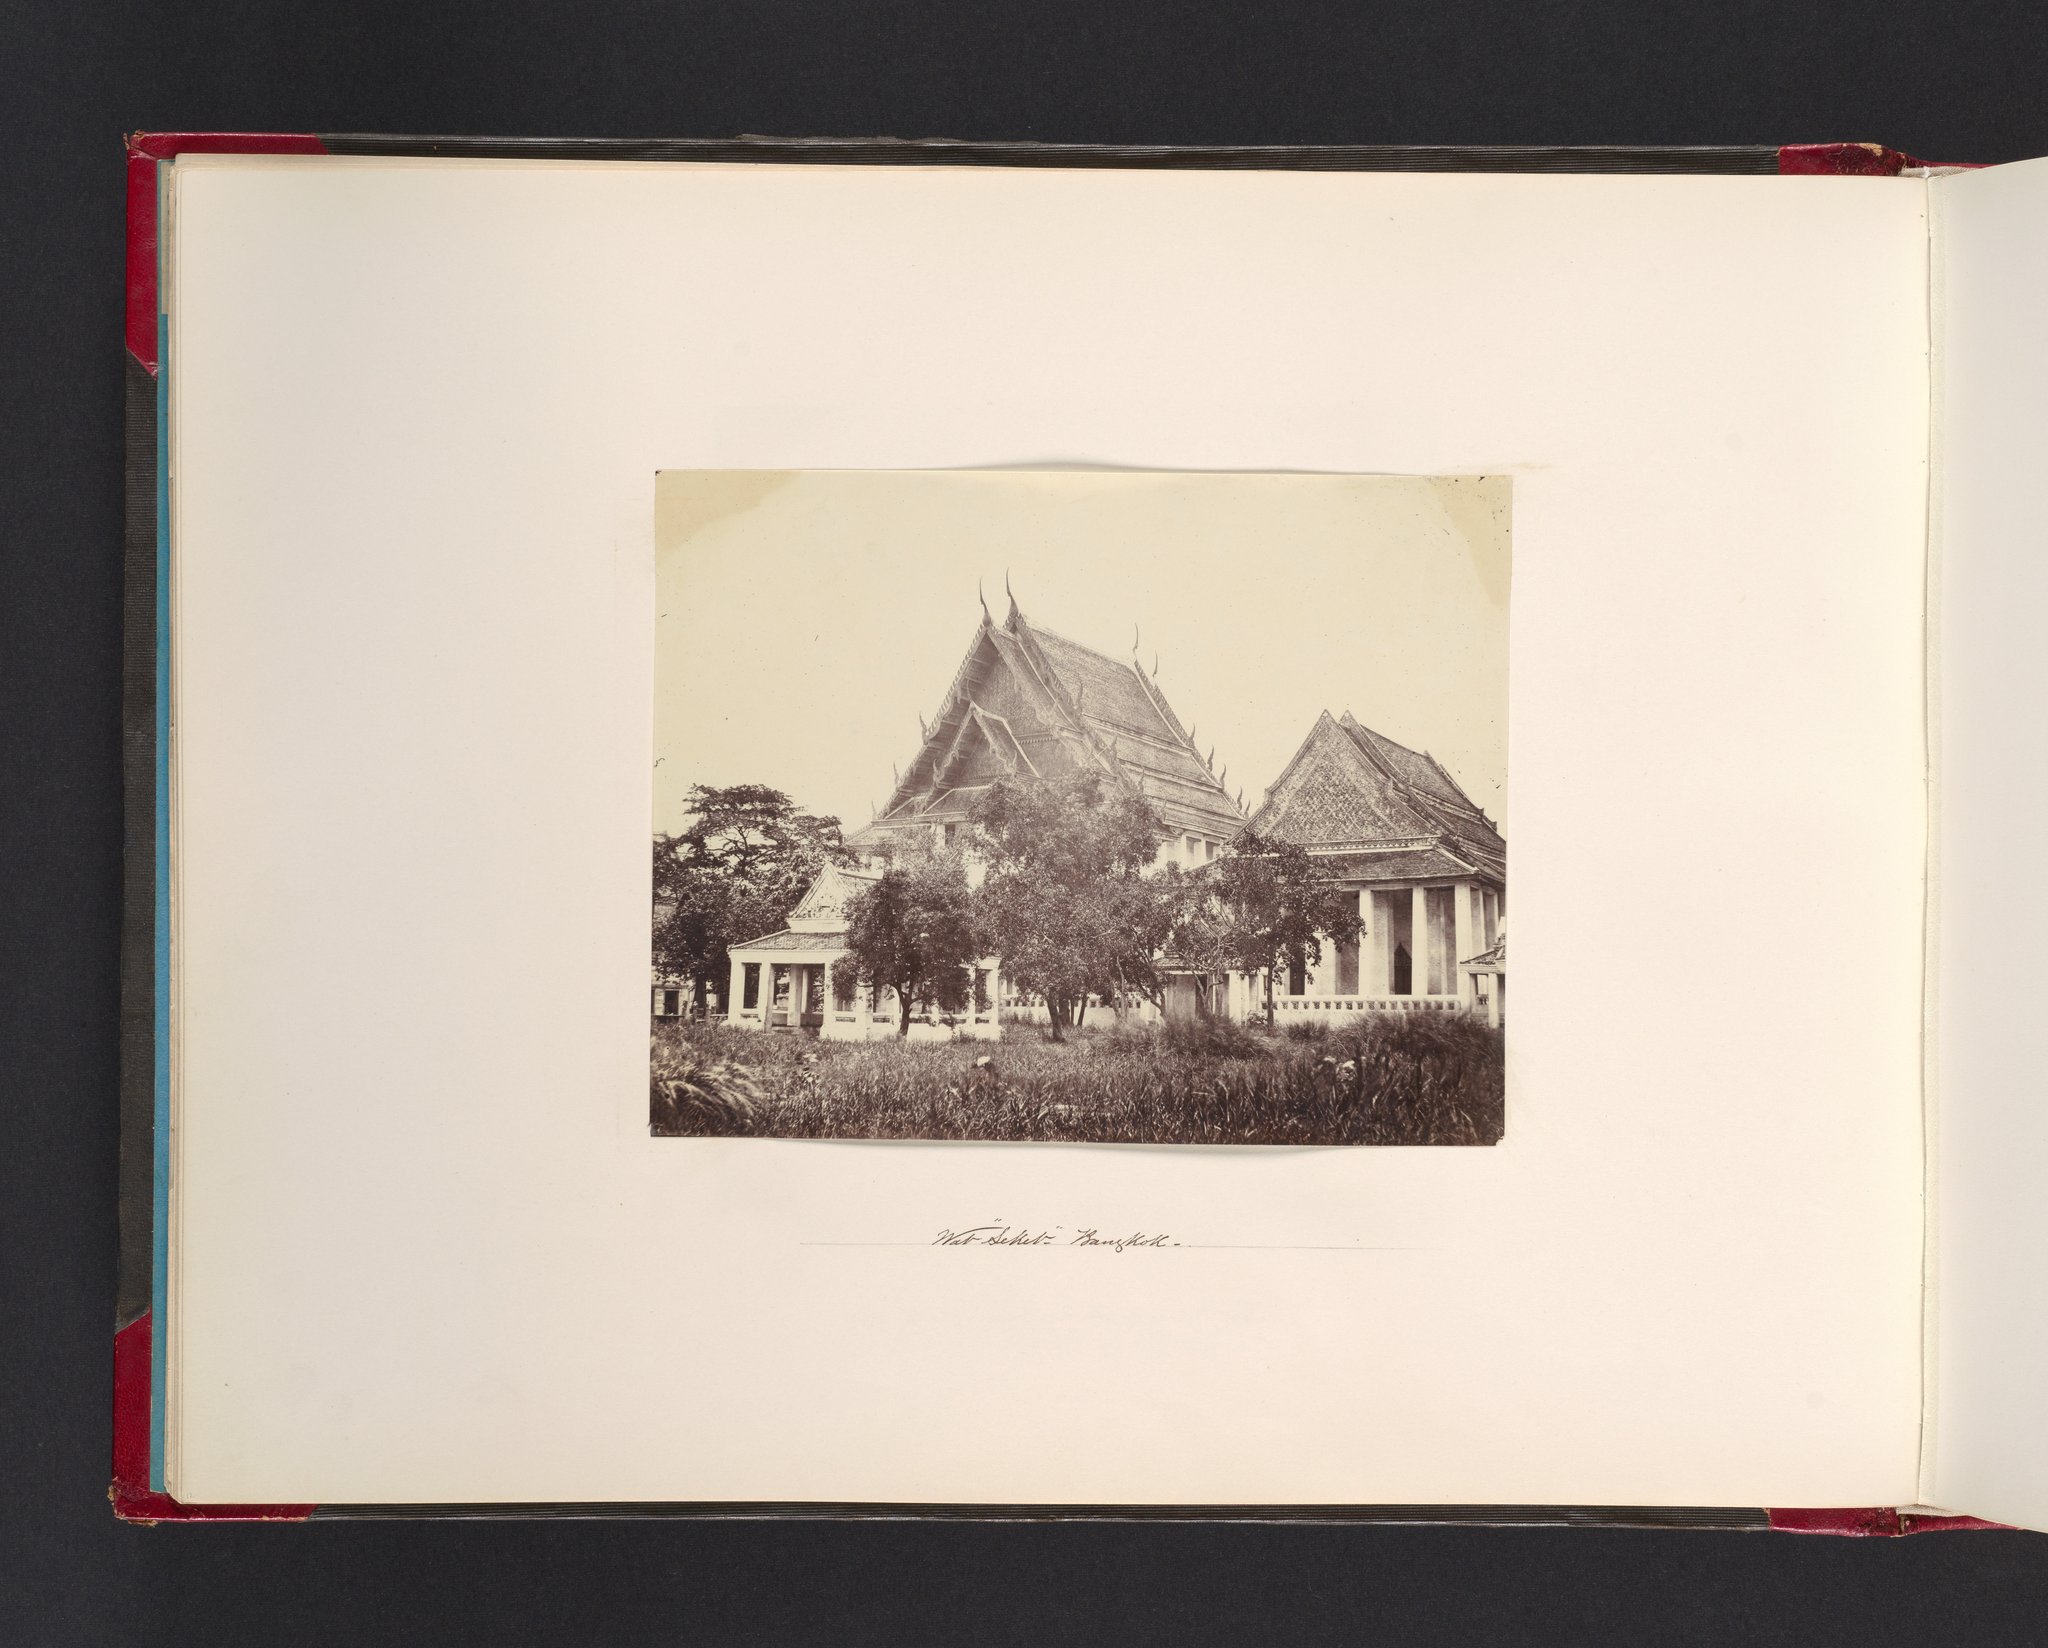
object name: photograph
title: Wat Seket, Bangkok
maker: john thomson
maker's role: artist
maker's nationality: british, scottish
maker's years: 1837-1921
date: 1865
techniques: albumen silver print, glass negative